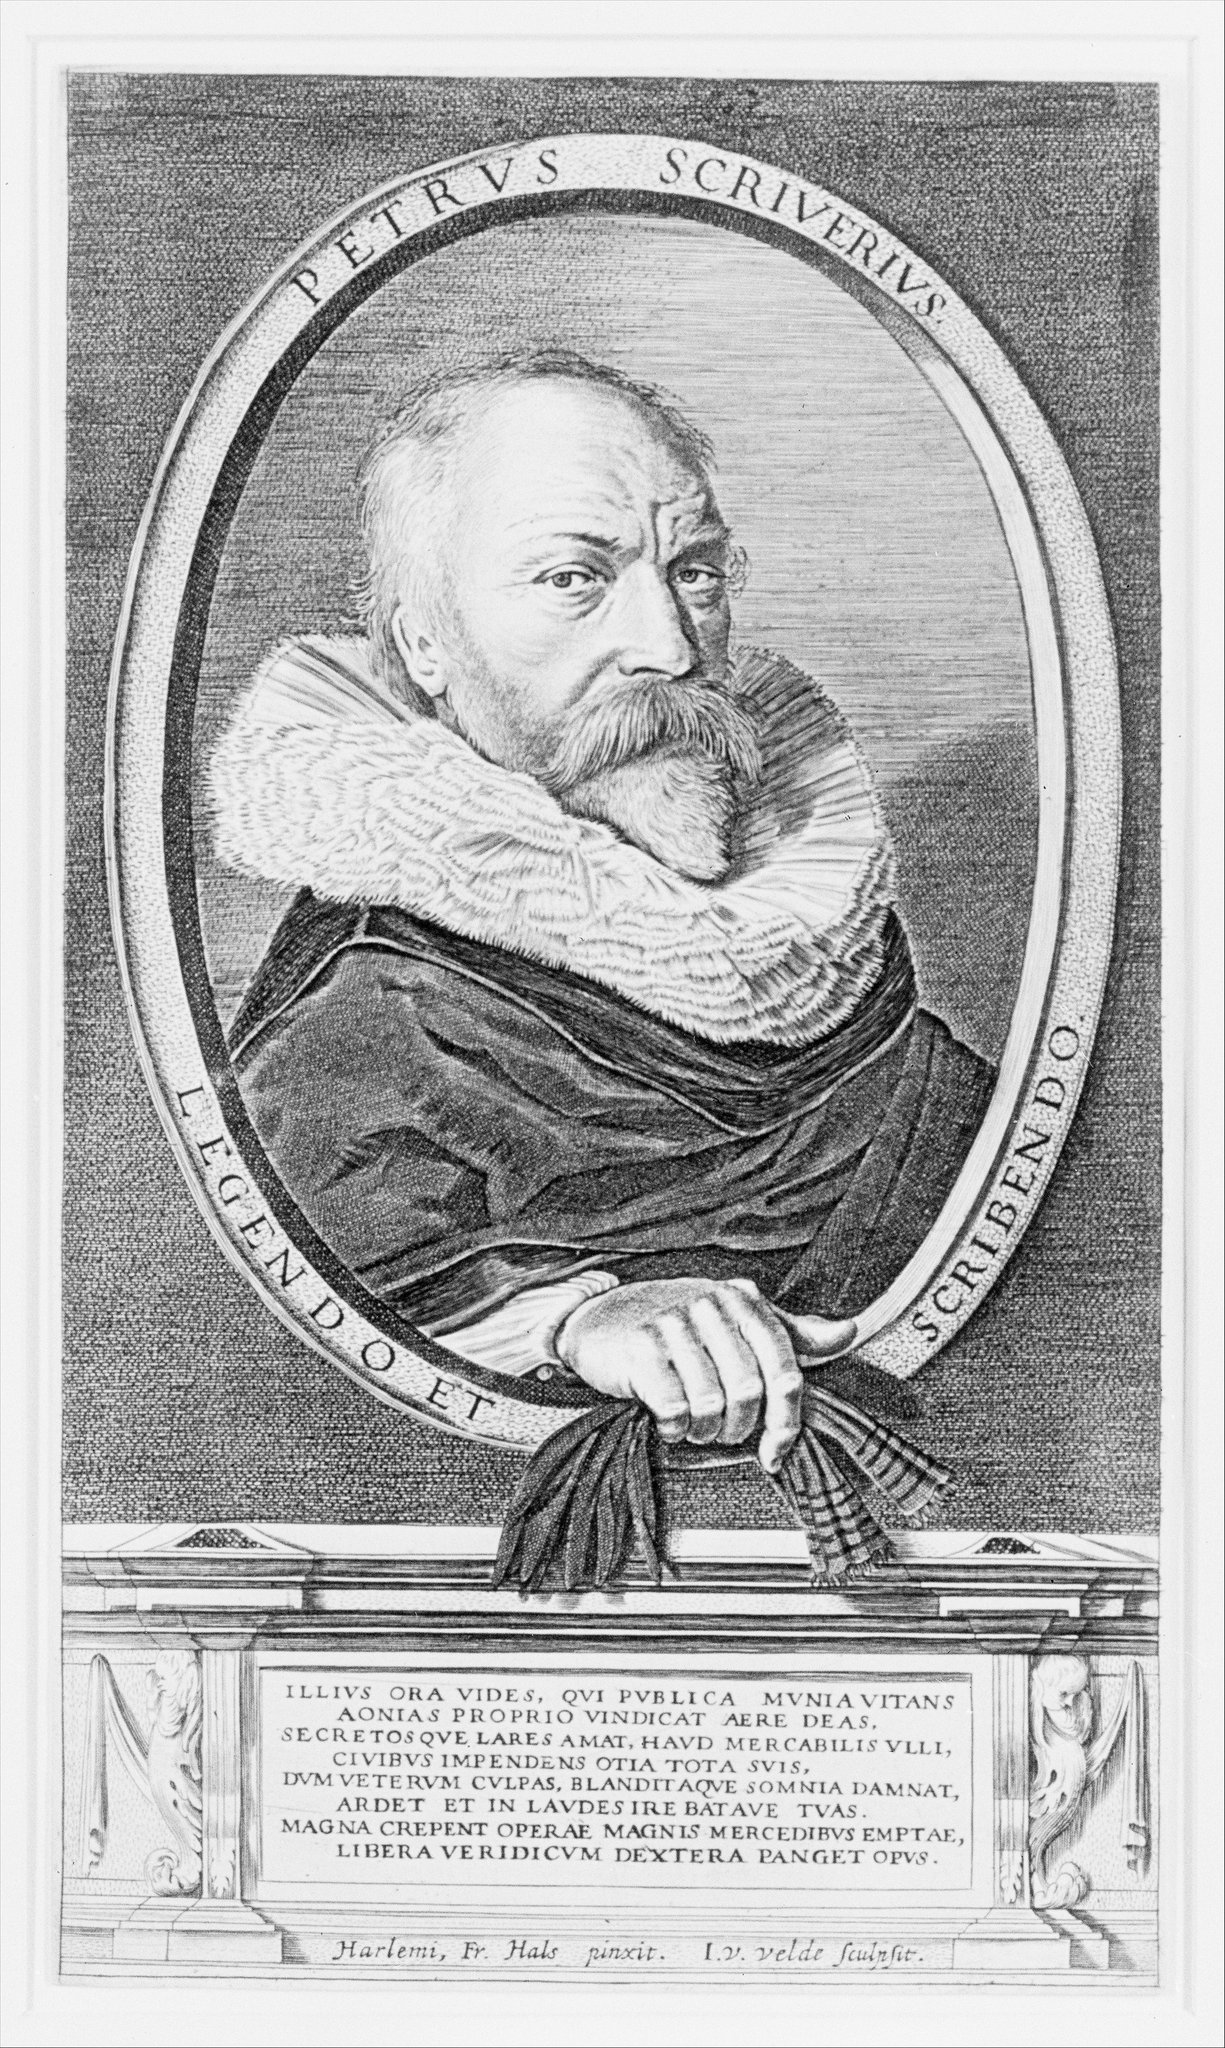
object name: print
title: Portrait of Peter Scriverius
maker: jan van de velde ii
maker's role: artist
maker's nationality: dutch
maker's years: 1593-1641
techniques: engraving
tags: men,portraits